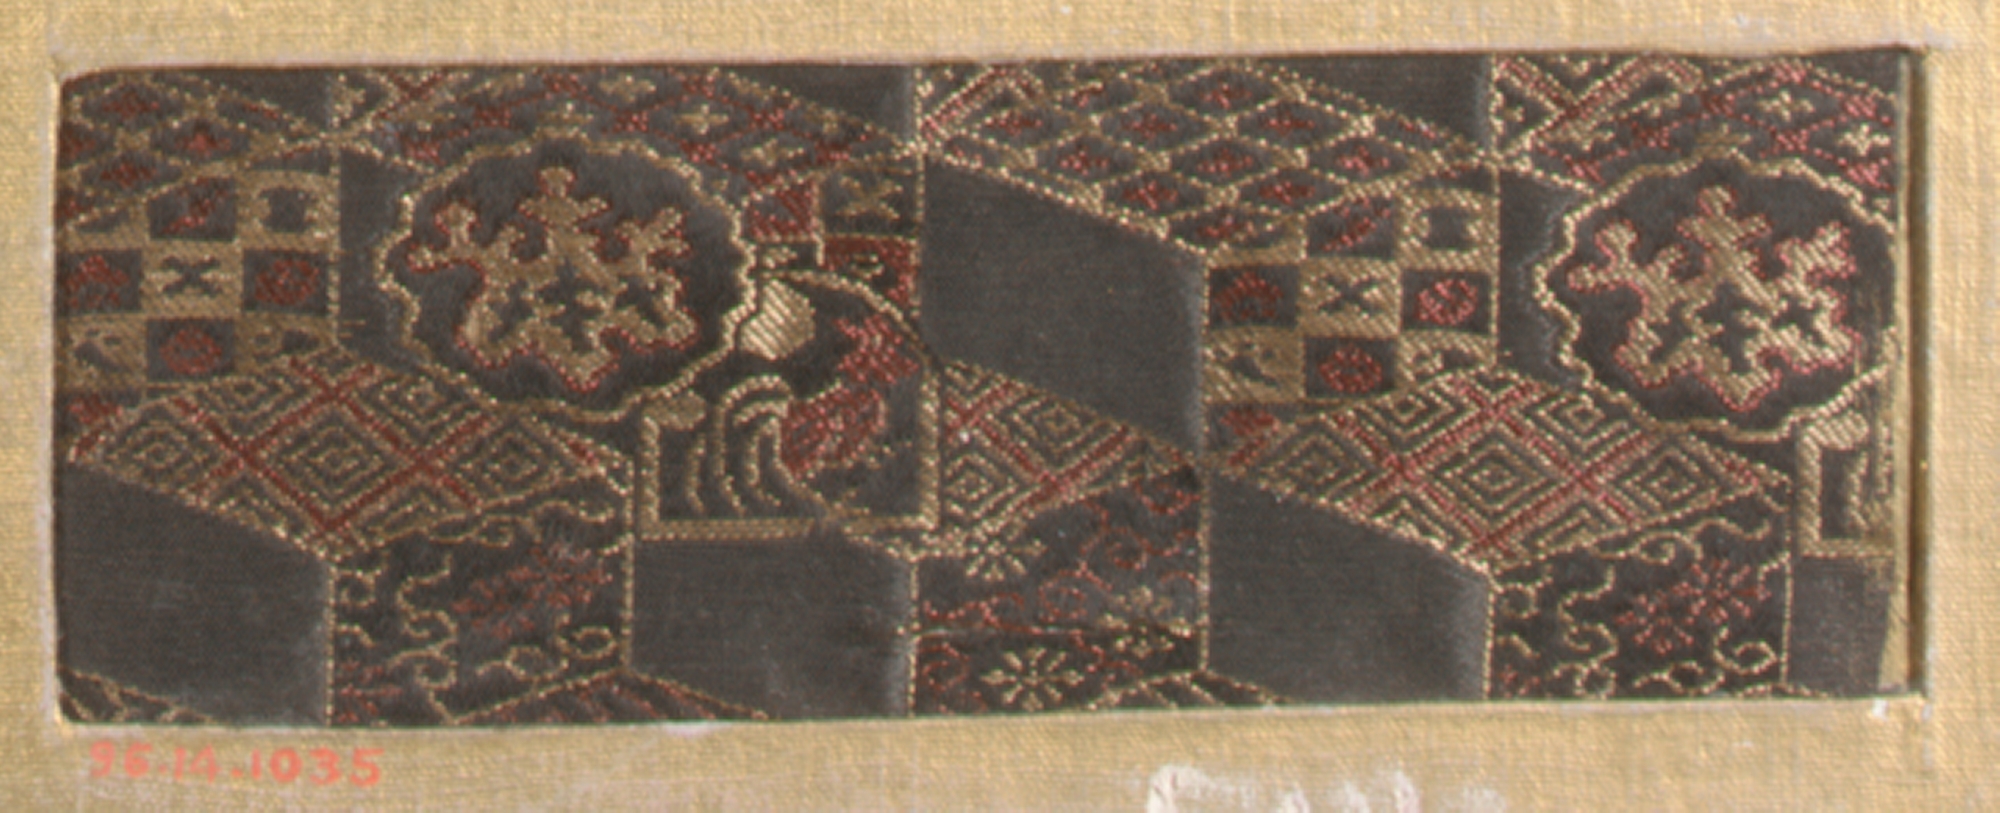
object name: piece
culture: japanese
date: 1701-1900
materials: silk